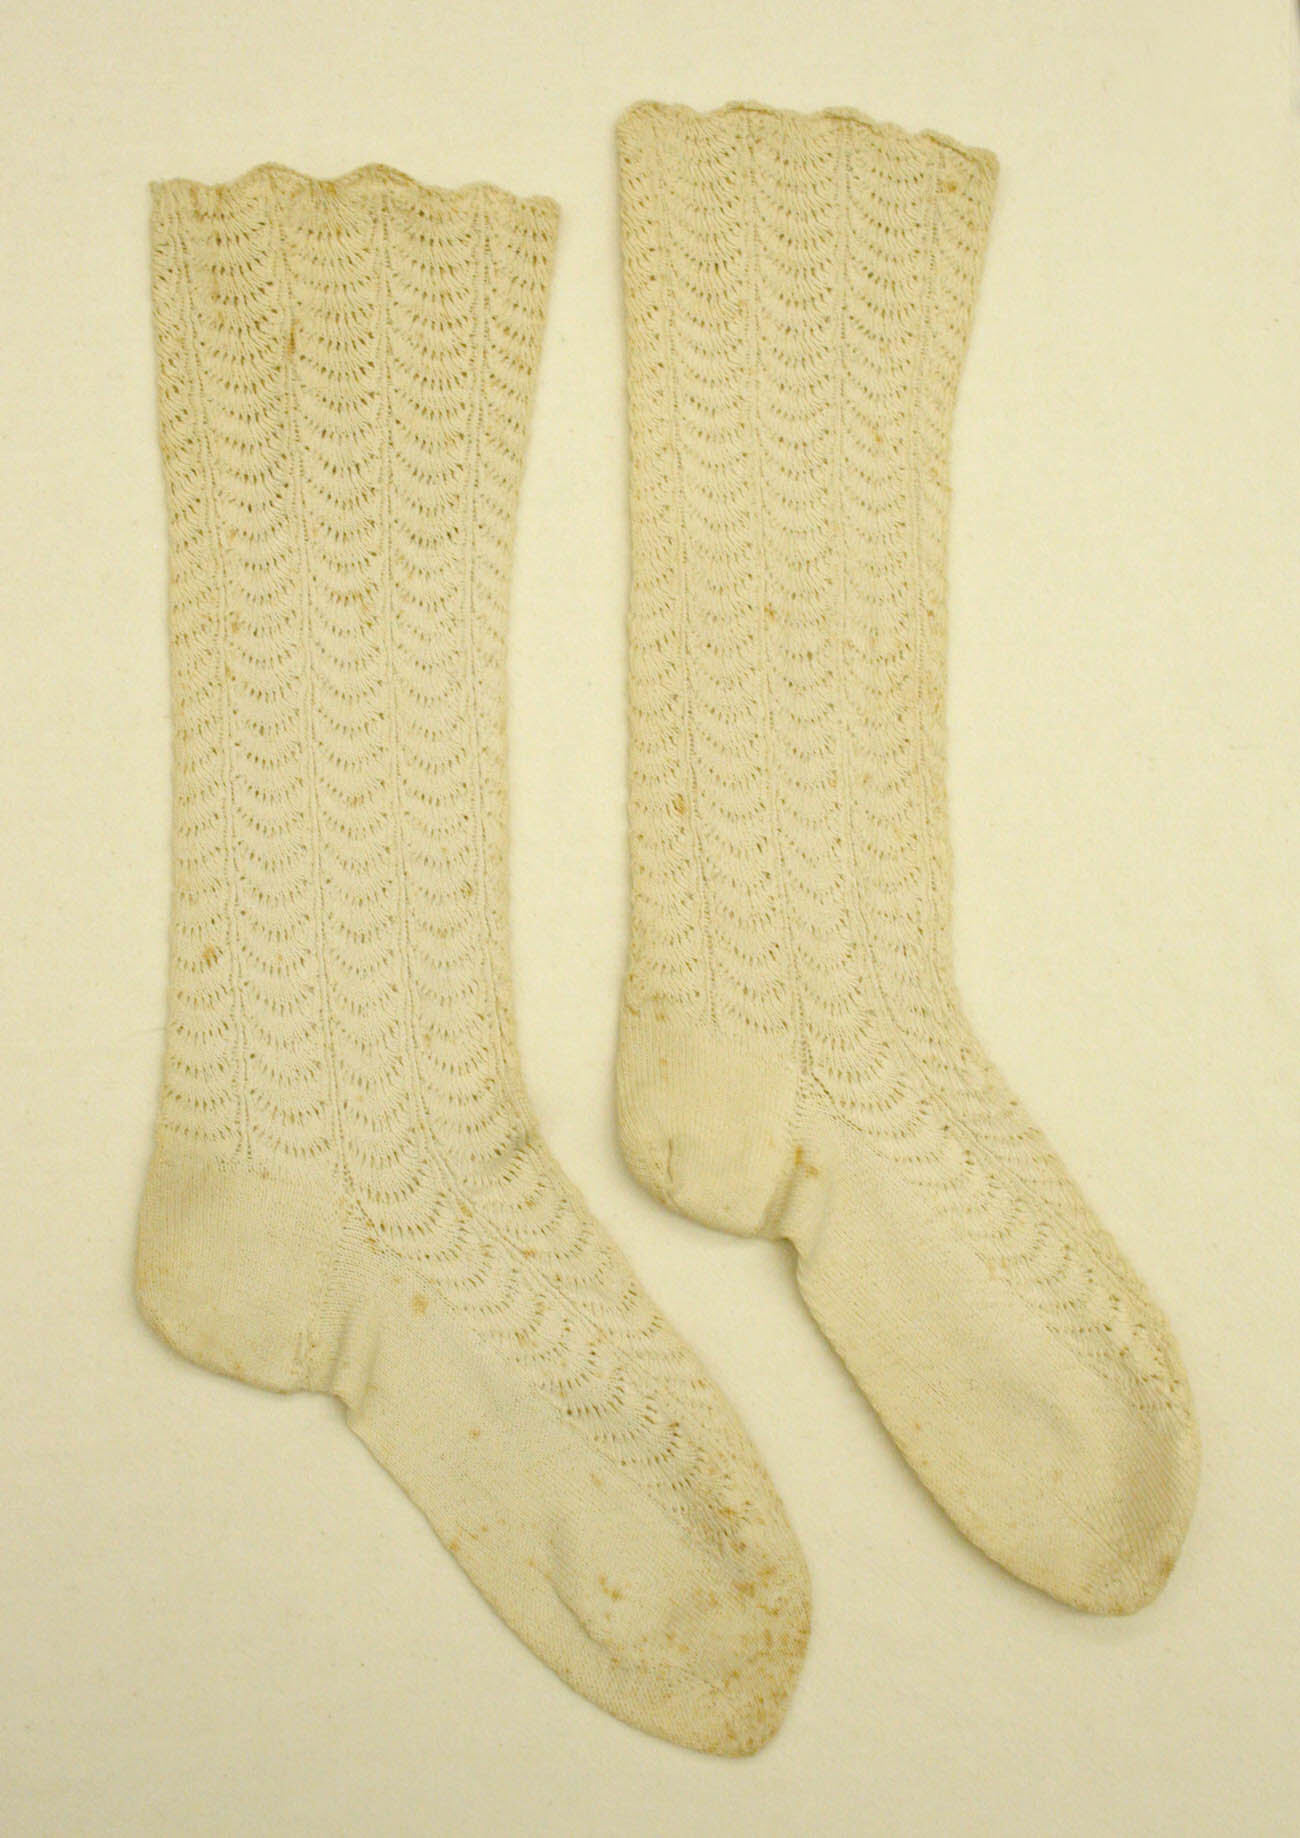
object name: stocking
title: Stockings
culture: american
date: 1860-1869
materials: cotton